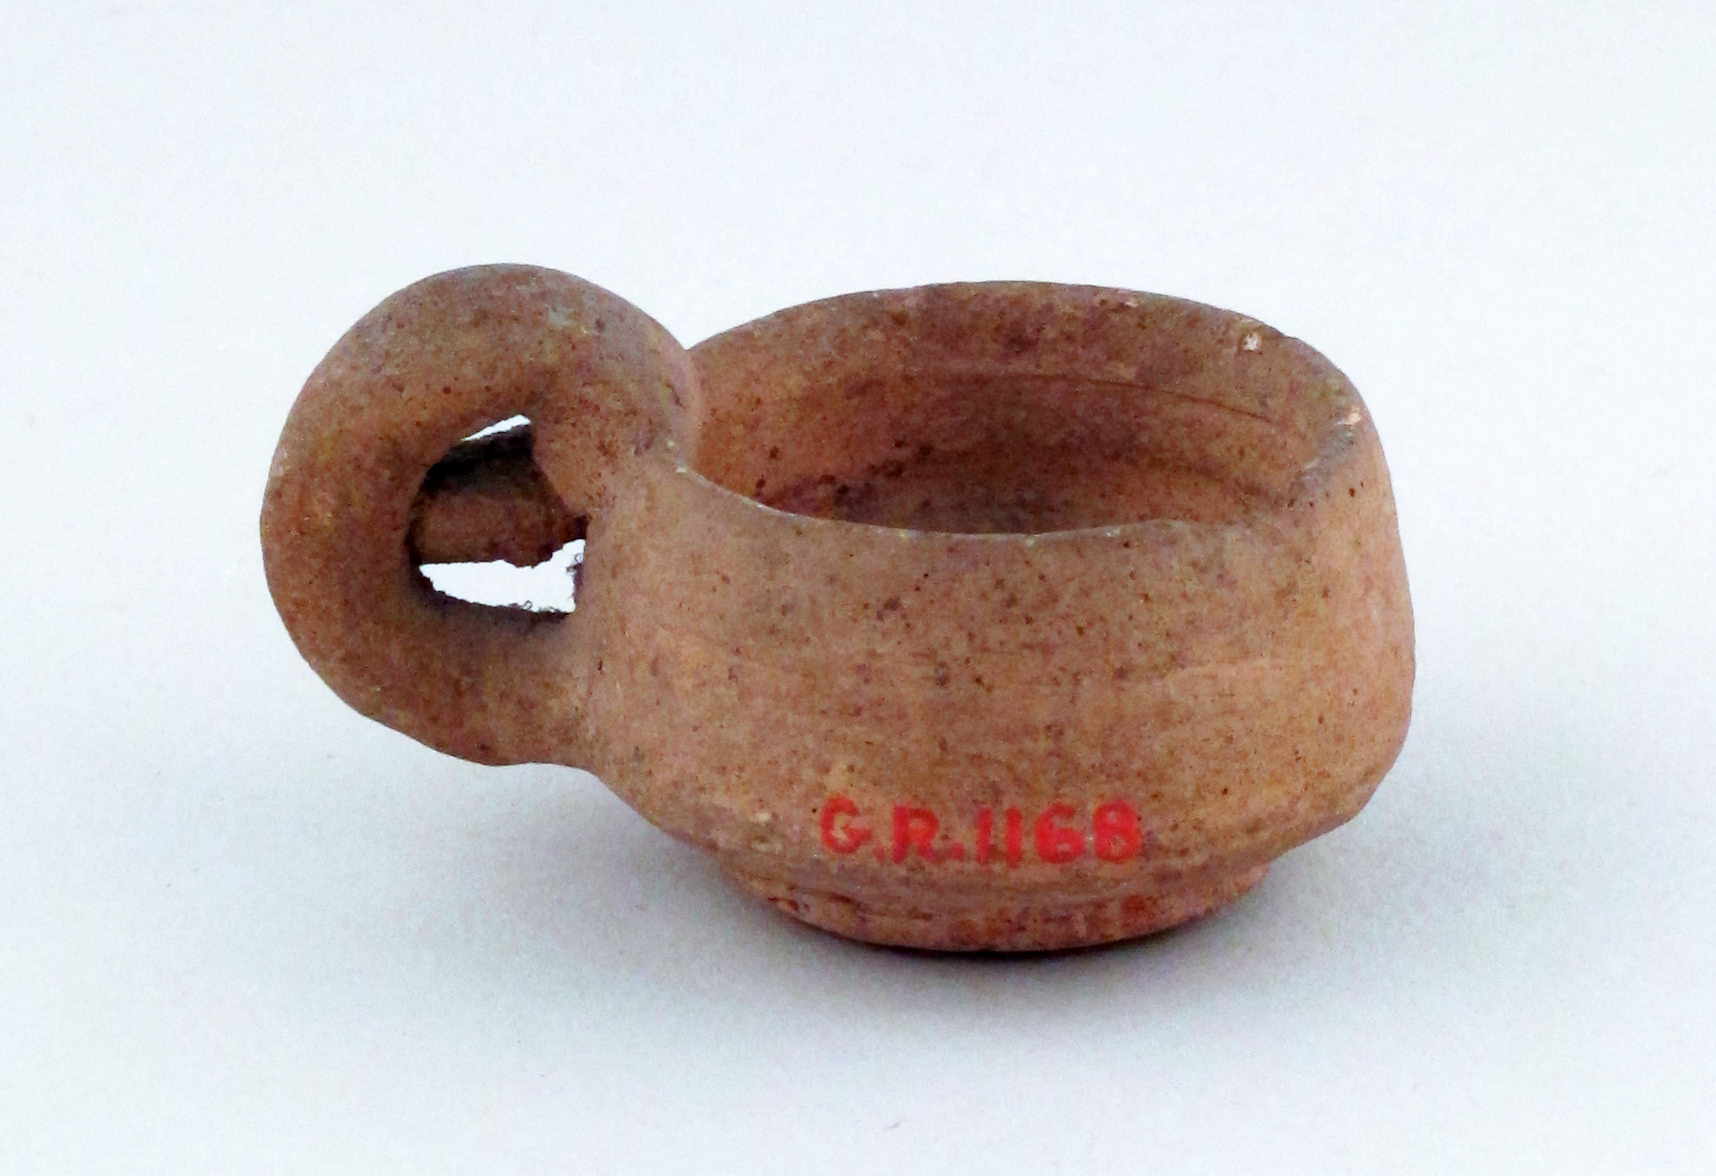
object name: cup, miniature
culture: etruscan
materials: terracotta